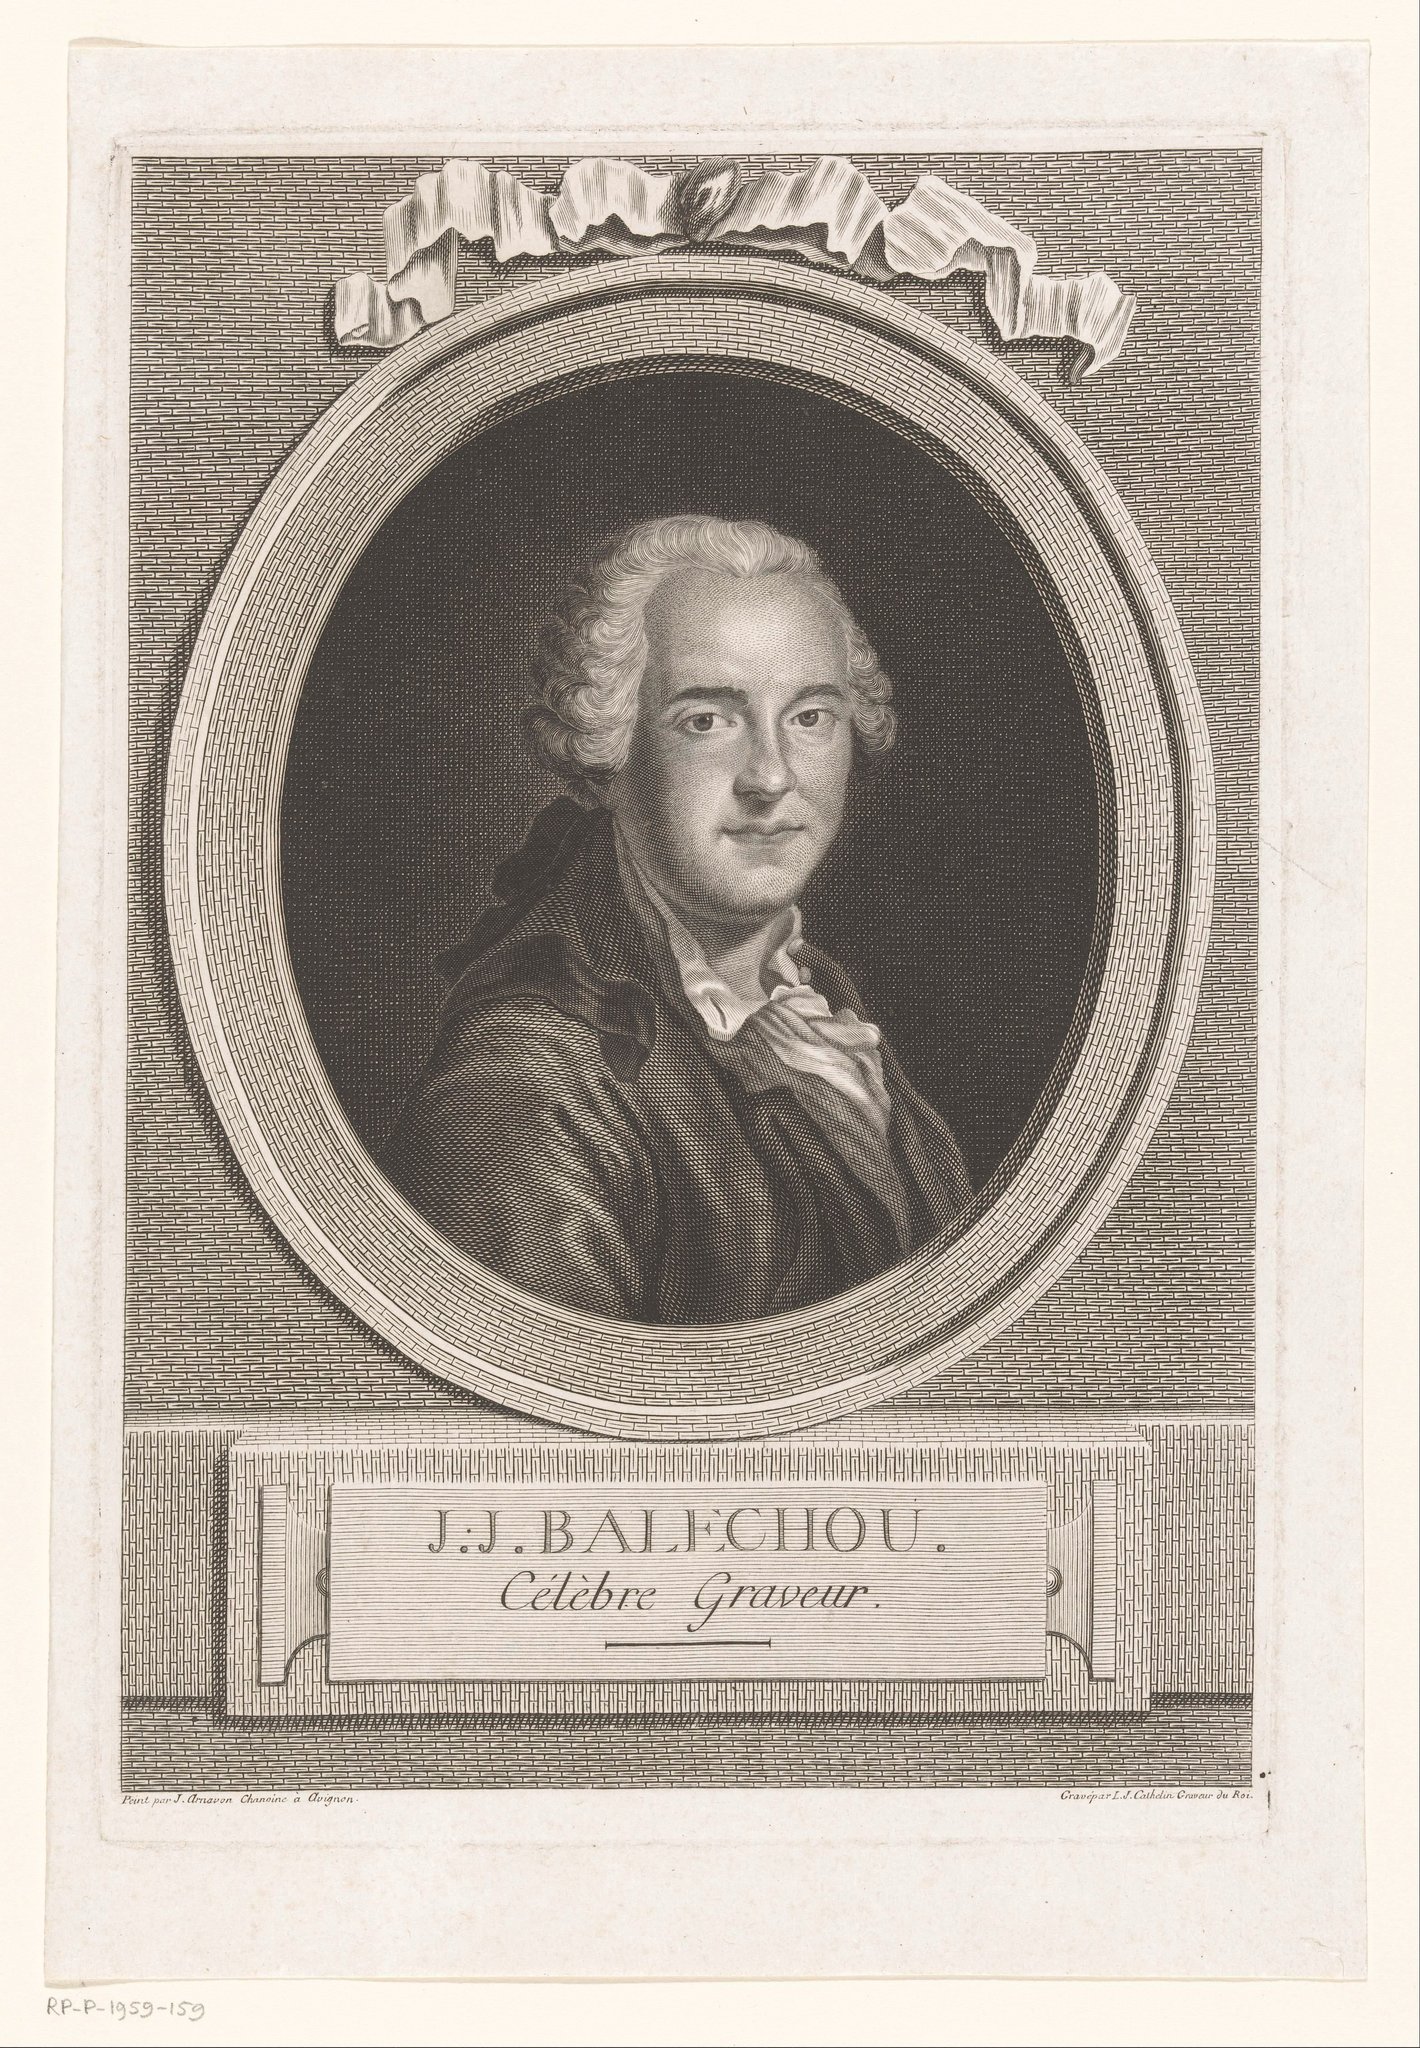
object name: print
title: Portret van Jean Joseph Baléchou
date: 1789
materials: paper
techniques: engraving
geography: france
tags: jean joseph baléchou, historical persons, portrait, self-portrait of artist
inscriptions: collector's mark: Lugt 2228, collector's mark: Lugt 2760